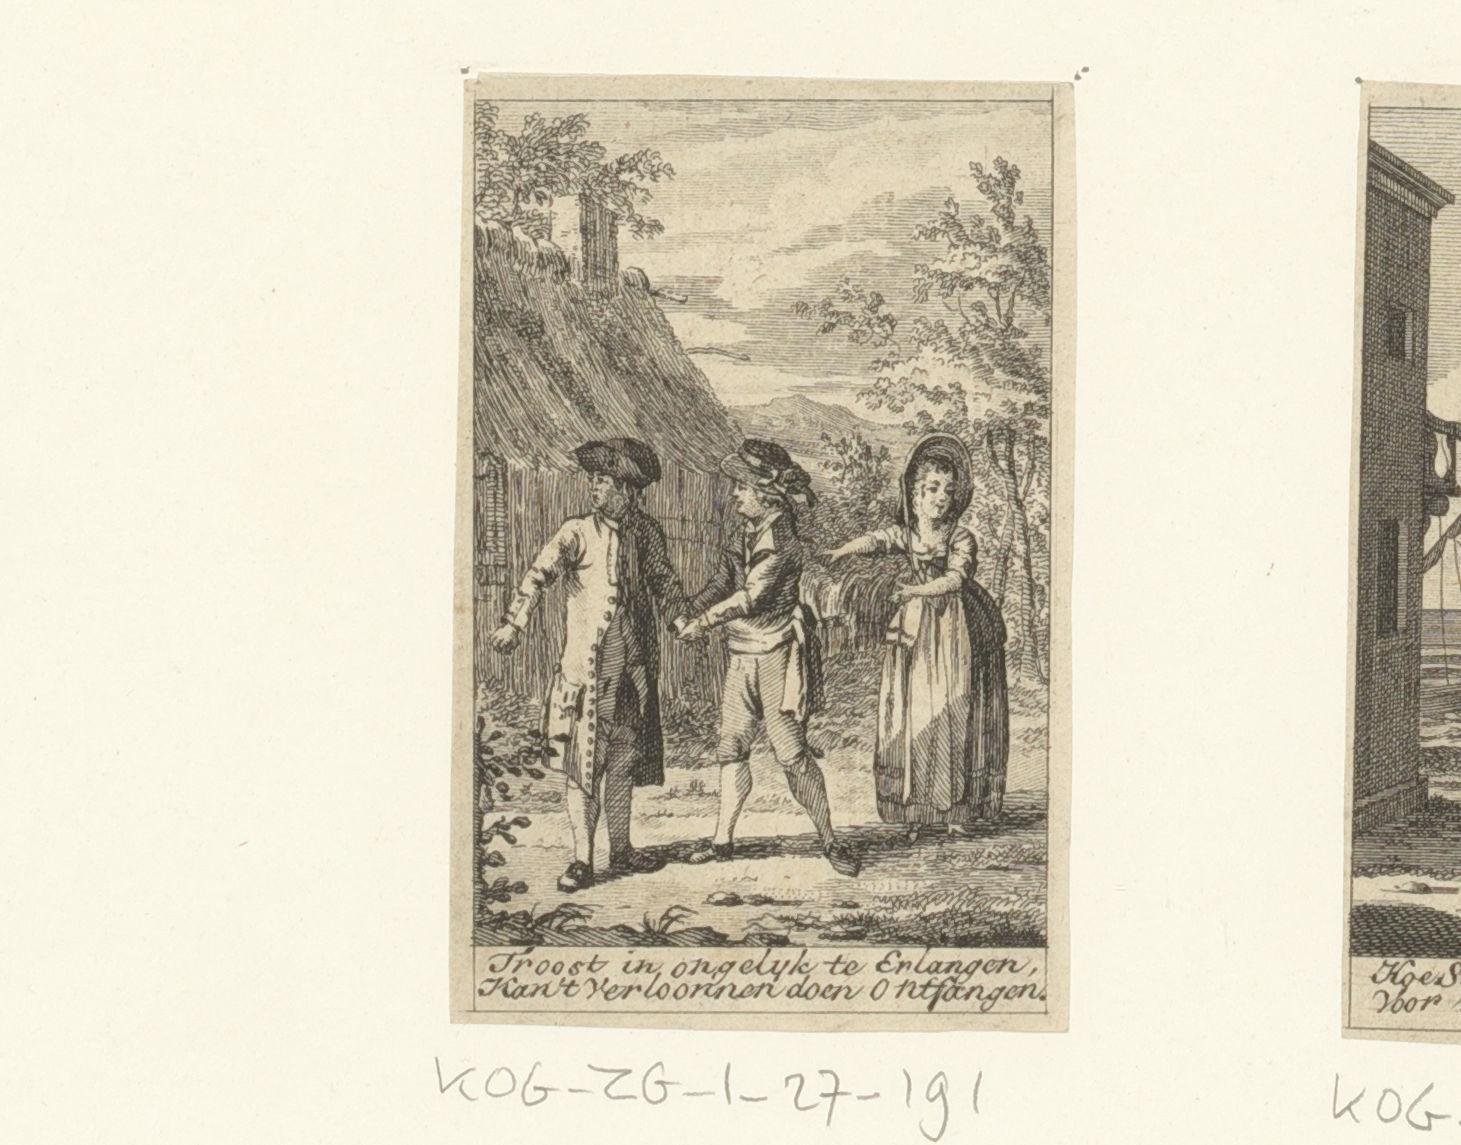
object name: book illustration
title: Een vriend wordt getroost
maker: Anonymous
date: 1725-1799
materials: paper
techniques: engraving, etching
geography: netherlands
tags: consolation, friends, gripping someone by the hand or the wrist; clasped hands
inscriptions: collector's mark: Lugt 1641, collector's mark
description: Gebruikt als illustratie in een onbekende almanak.